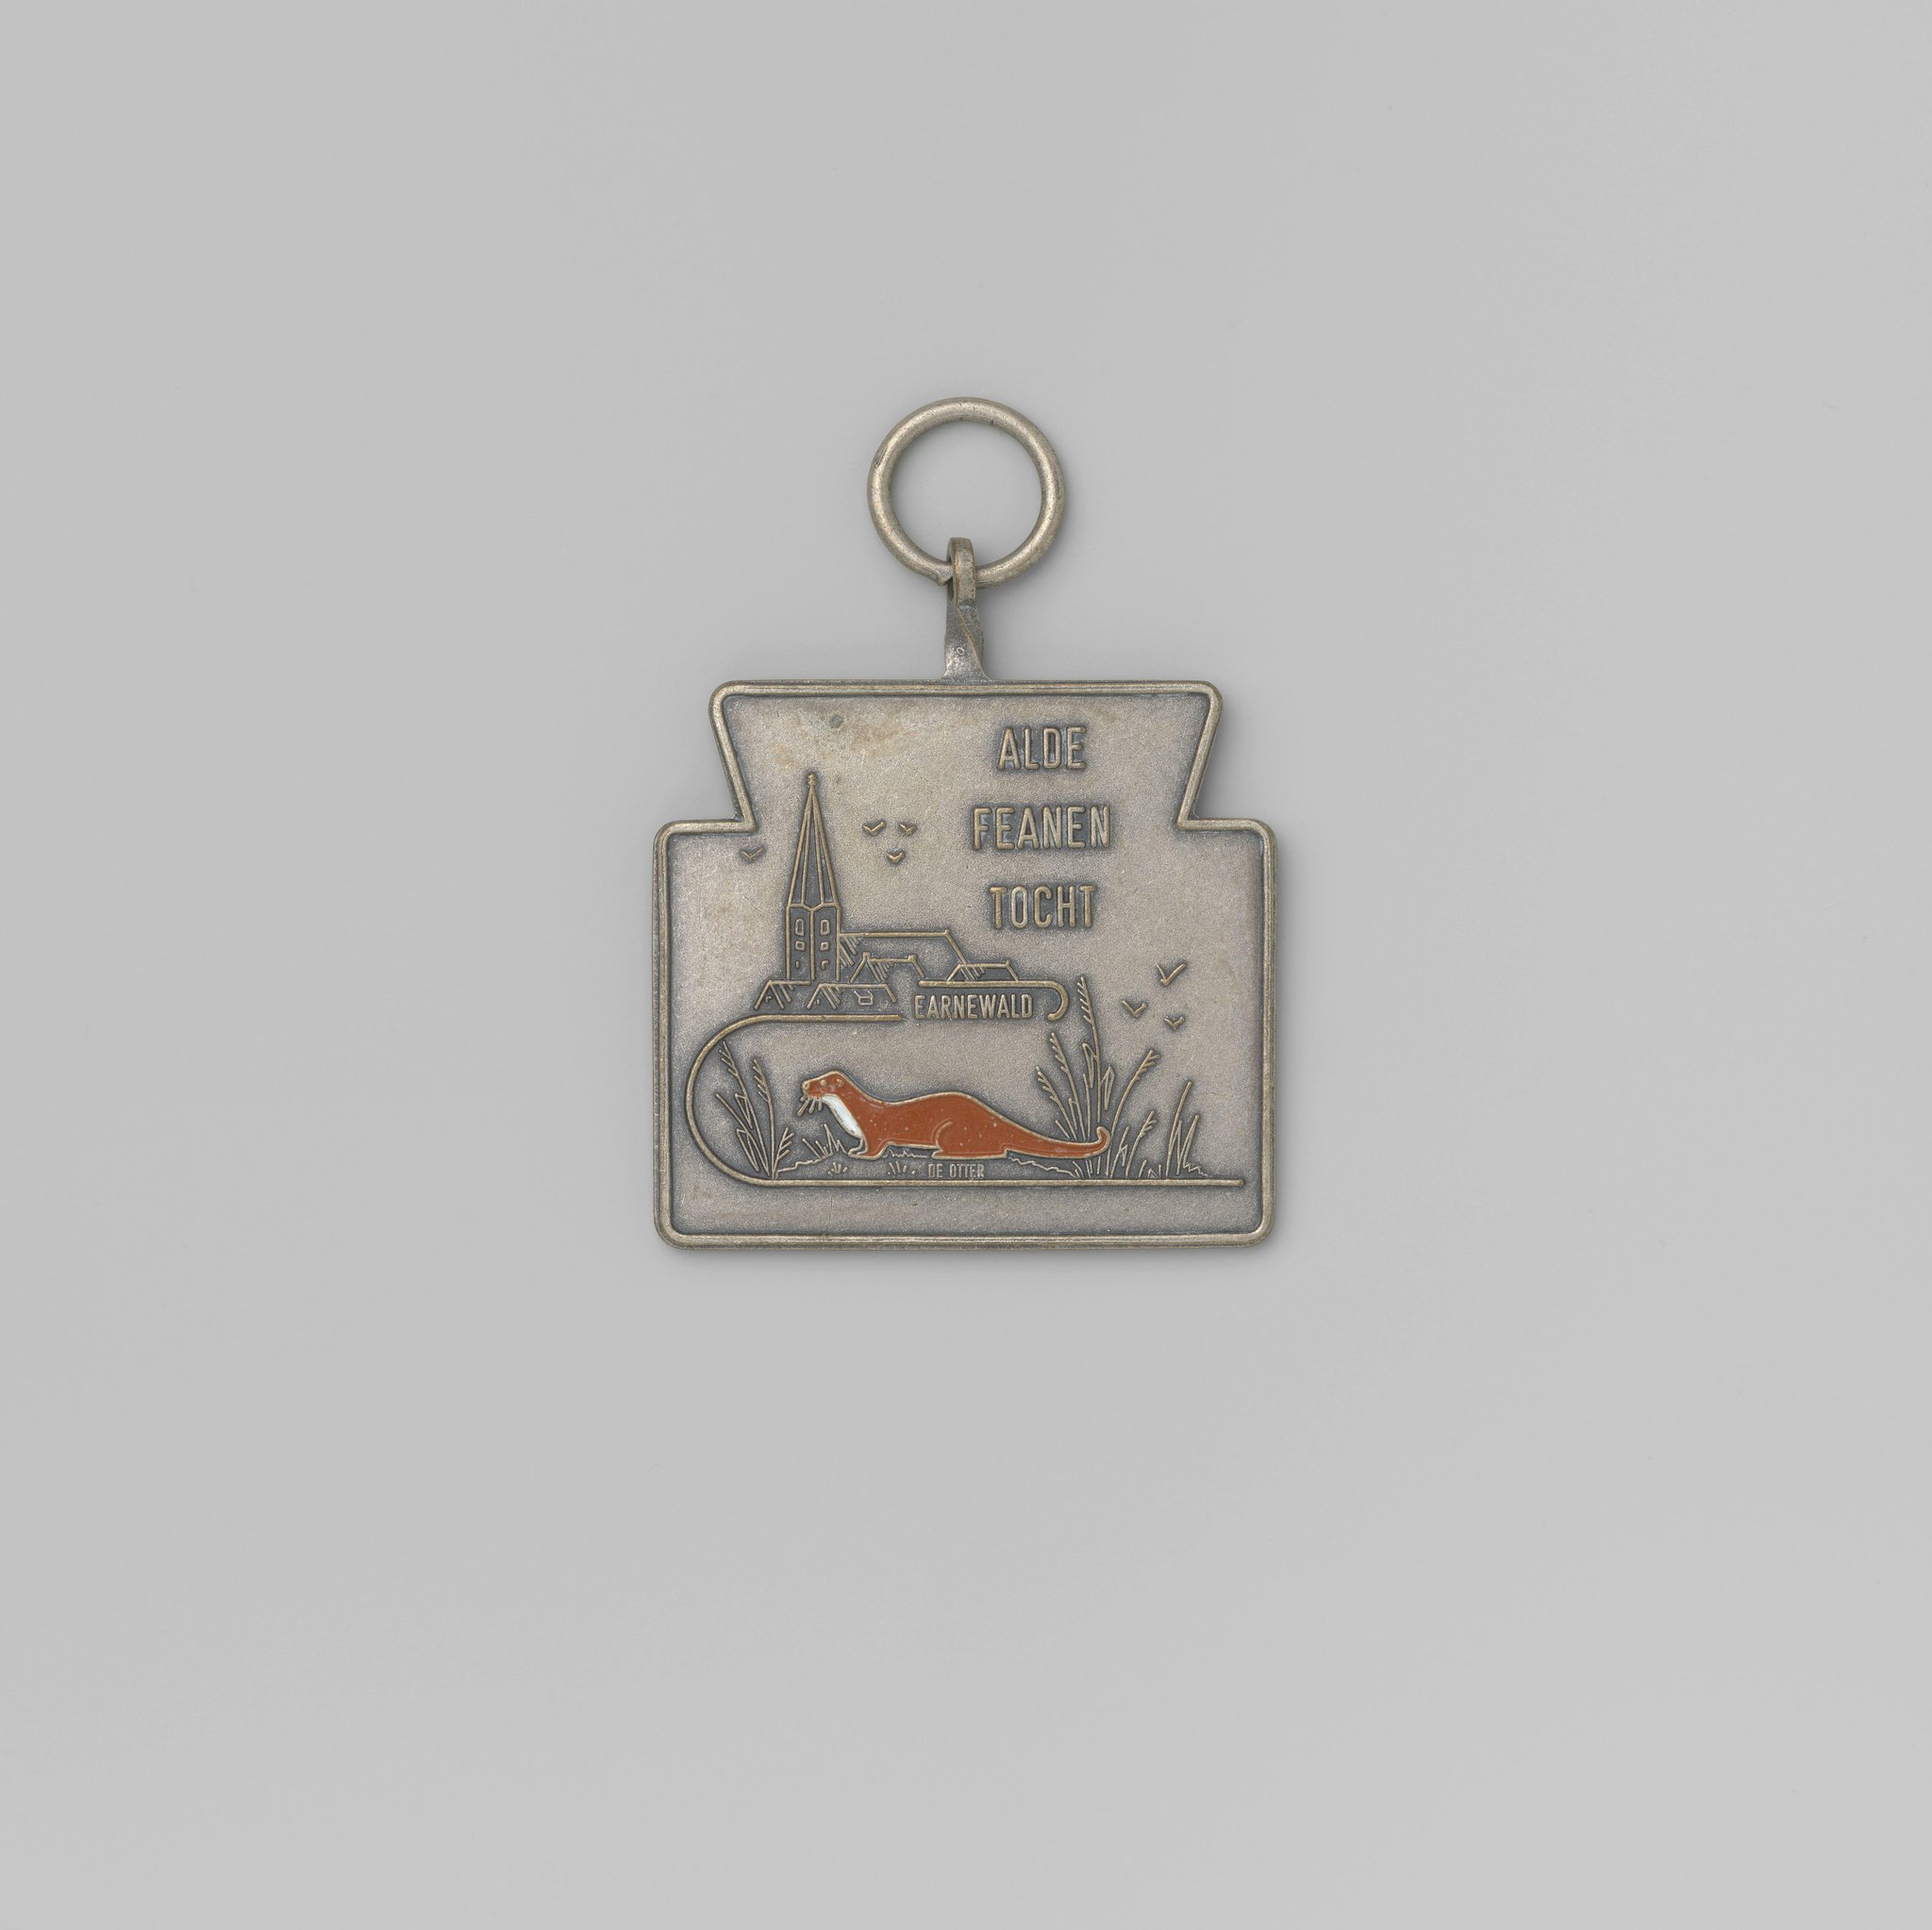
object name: onderscheidingsteken, onderscheiding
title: Onderscheiding Alde Feanen Tocht 1996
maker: Anonymous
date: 1996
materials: metal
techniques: striking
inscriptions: inscription: ‘25 KM 3-1-1996’